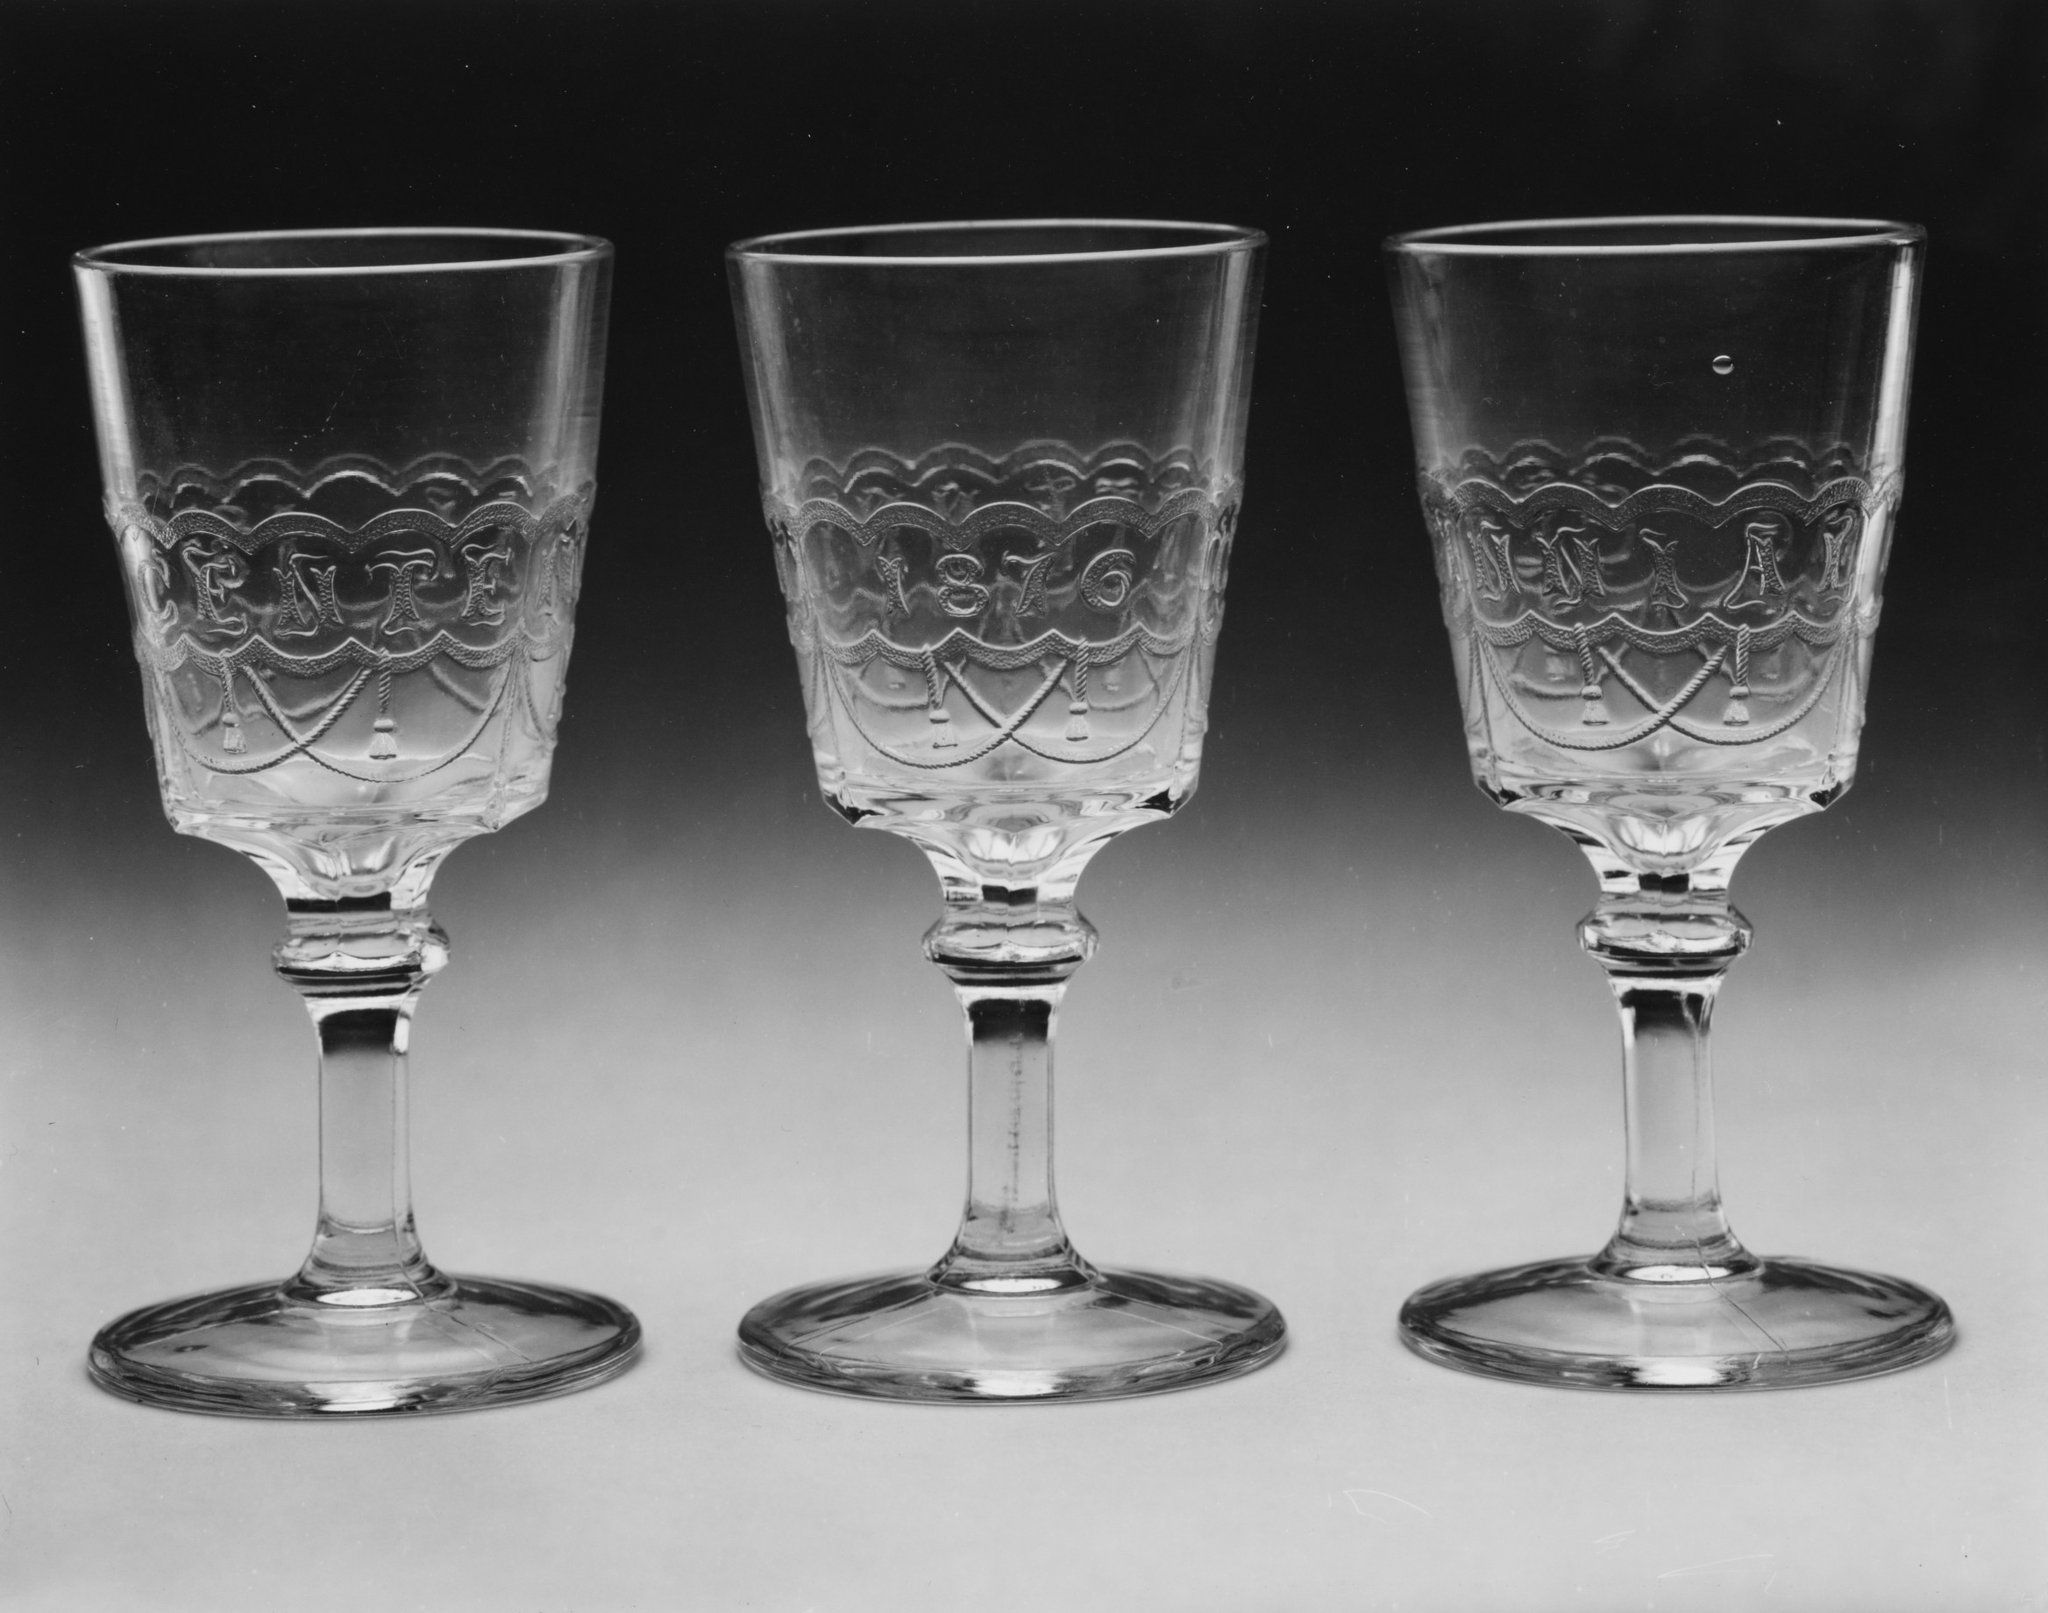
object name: goblet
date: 1876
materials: glass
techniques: glassblowing, molding